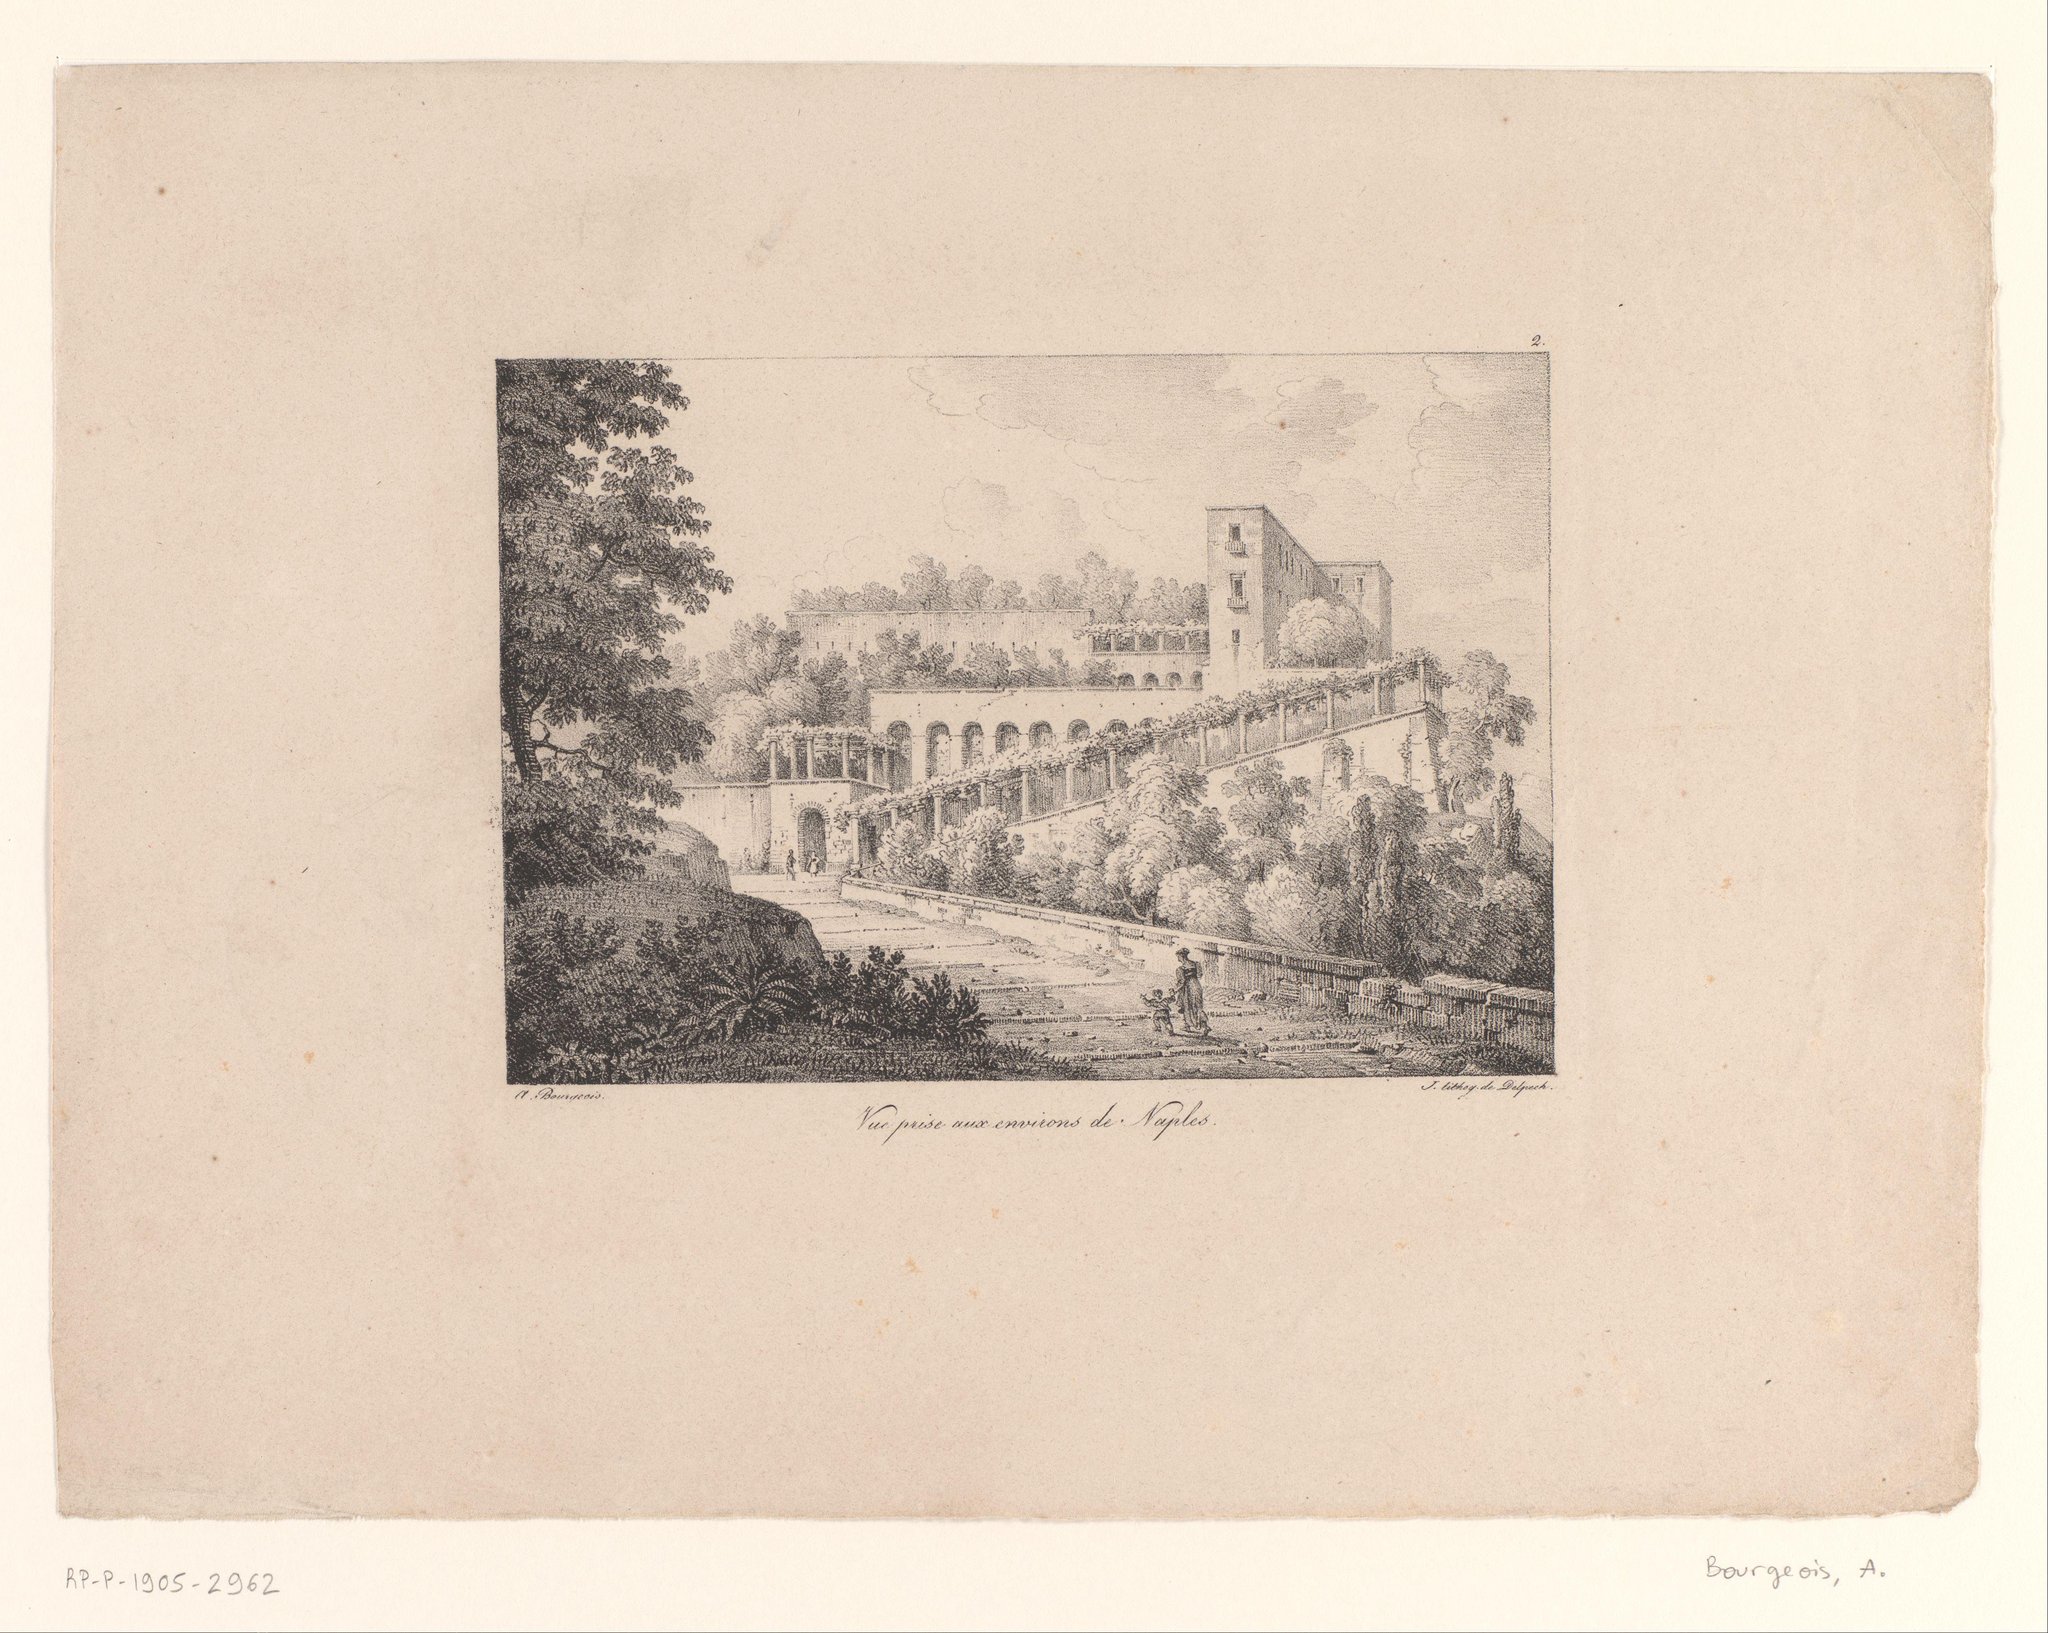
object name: print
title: Gezichten in Italië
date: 1825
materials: paper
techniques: lithograph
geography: paris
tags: rural housing, e.g. country-house, villa, cottage, naples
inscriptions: collector's mark: Lugt 2228a